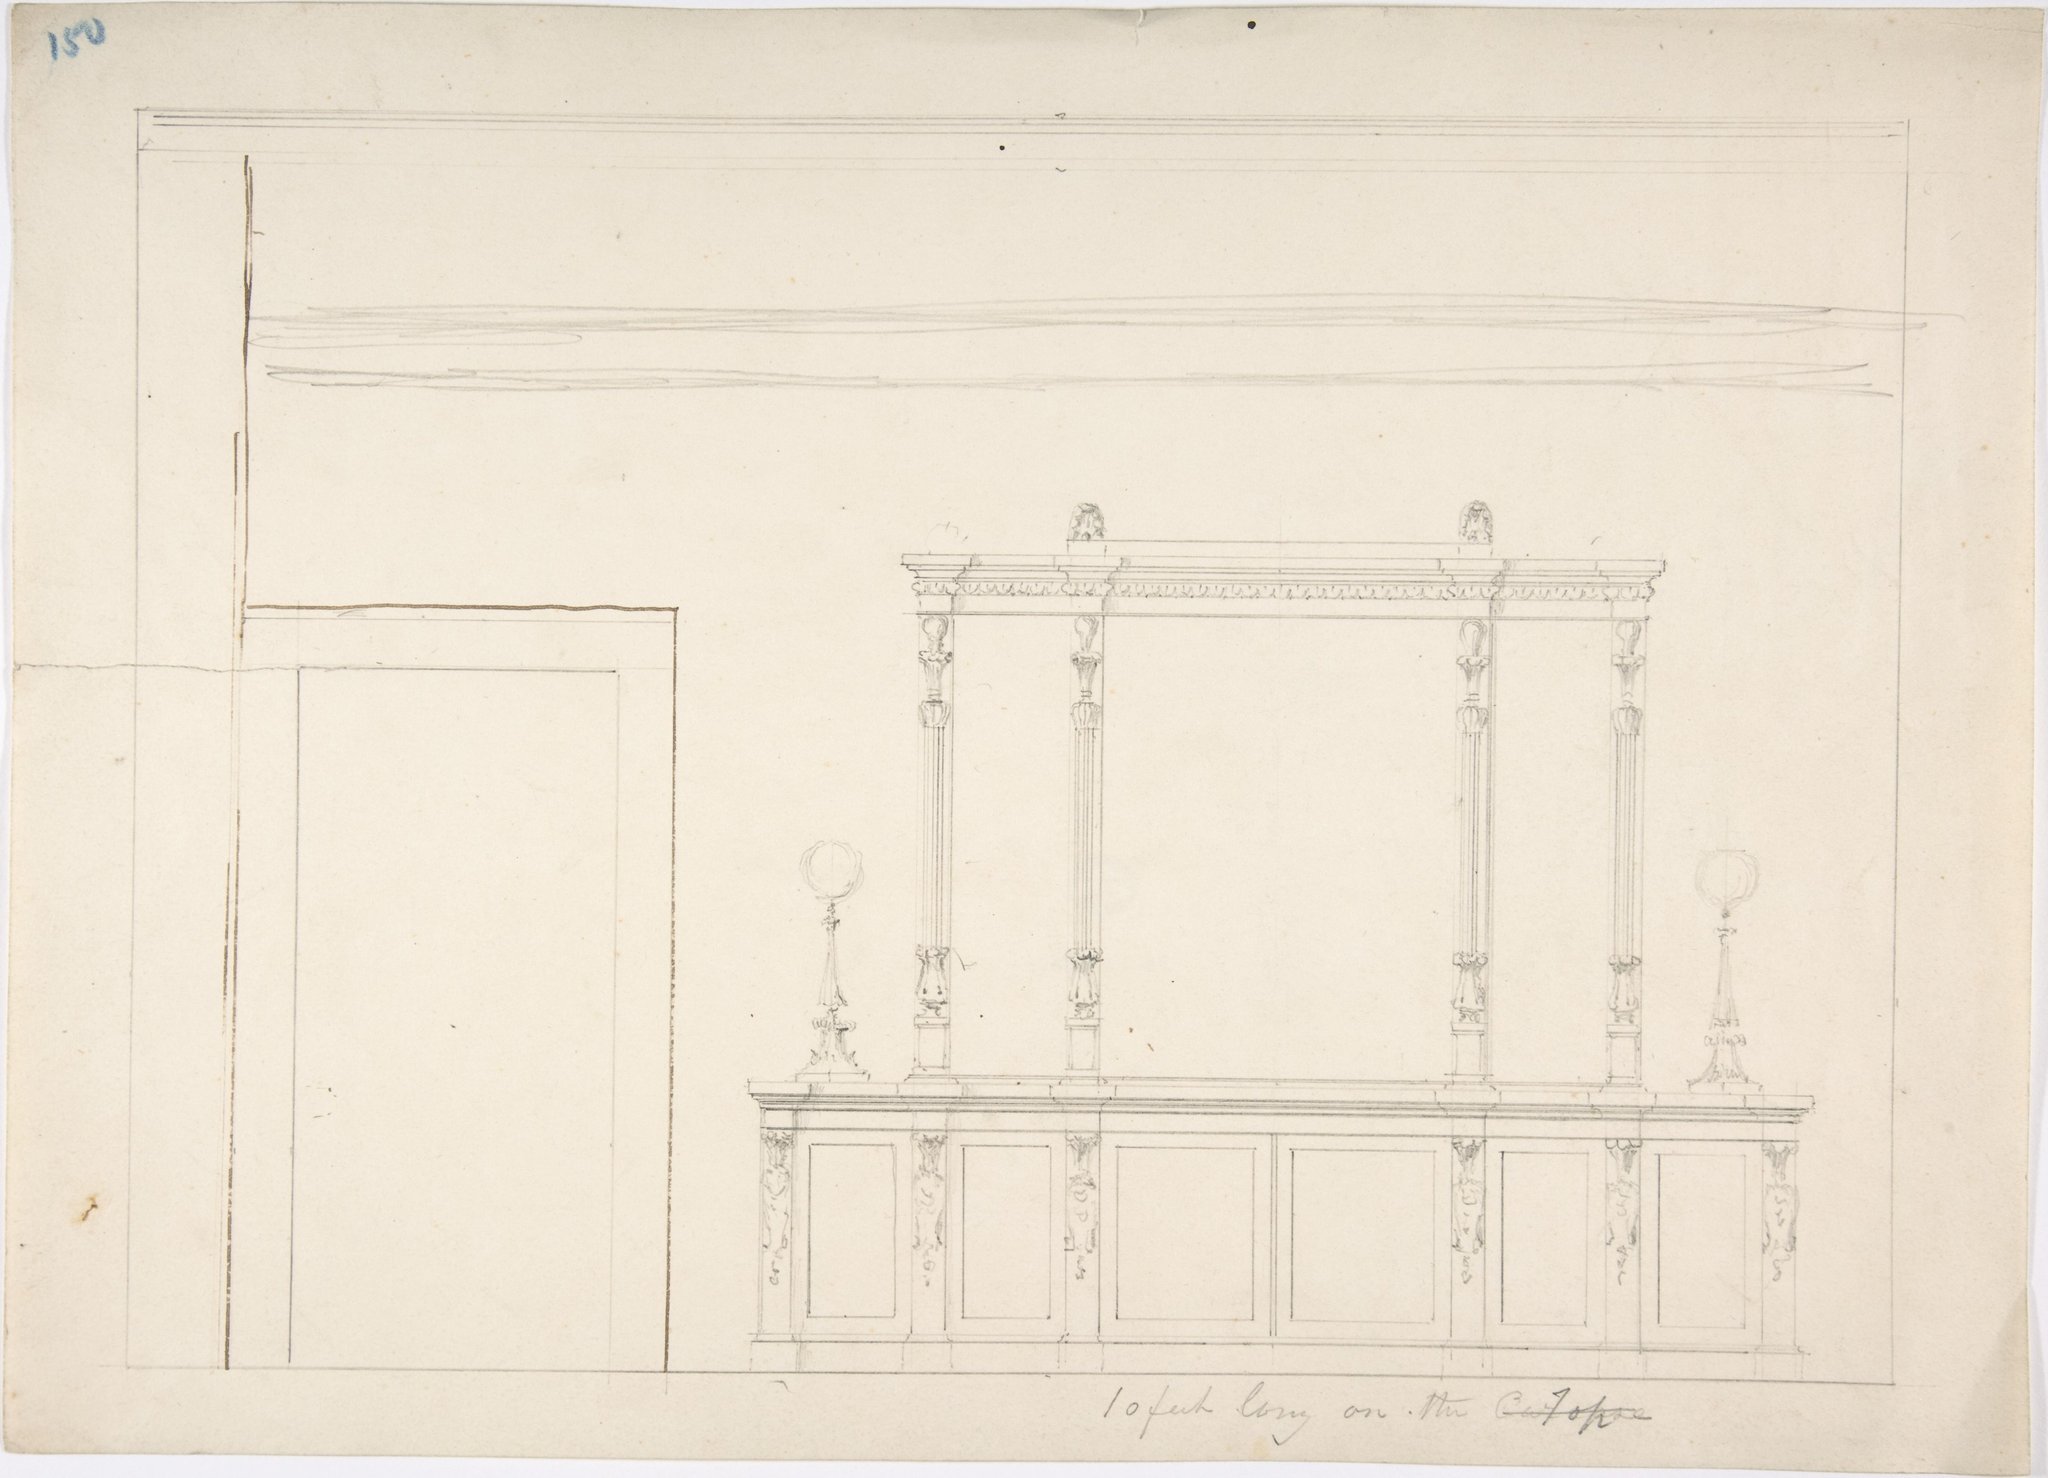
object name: drawing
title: Design for a Large Mirrored Cabinet Adorned with Two Lamps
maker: anonymous, british, 19th century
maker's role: artist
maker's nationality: british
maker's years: 1800-1900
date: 1801-1833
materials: graphite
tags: cabinets